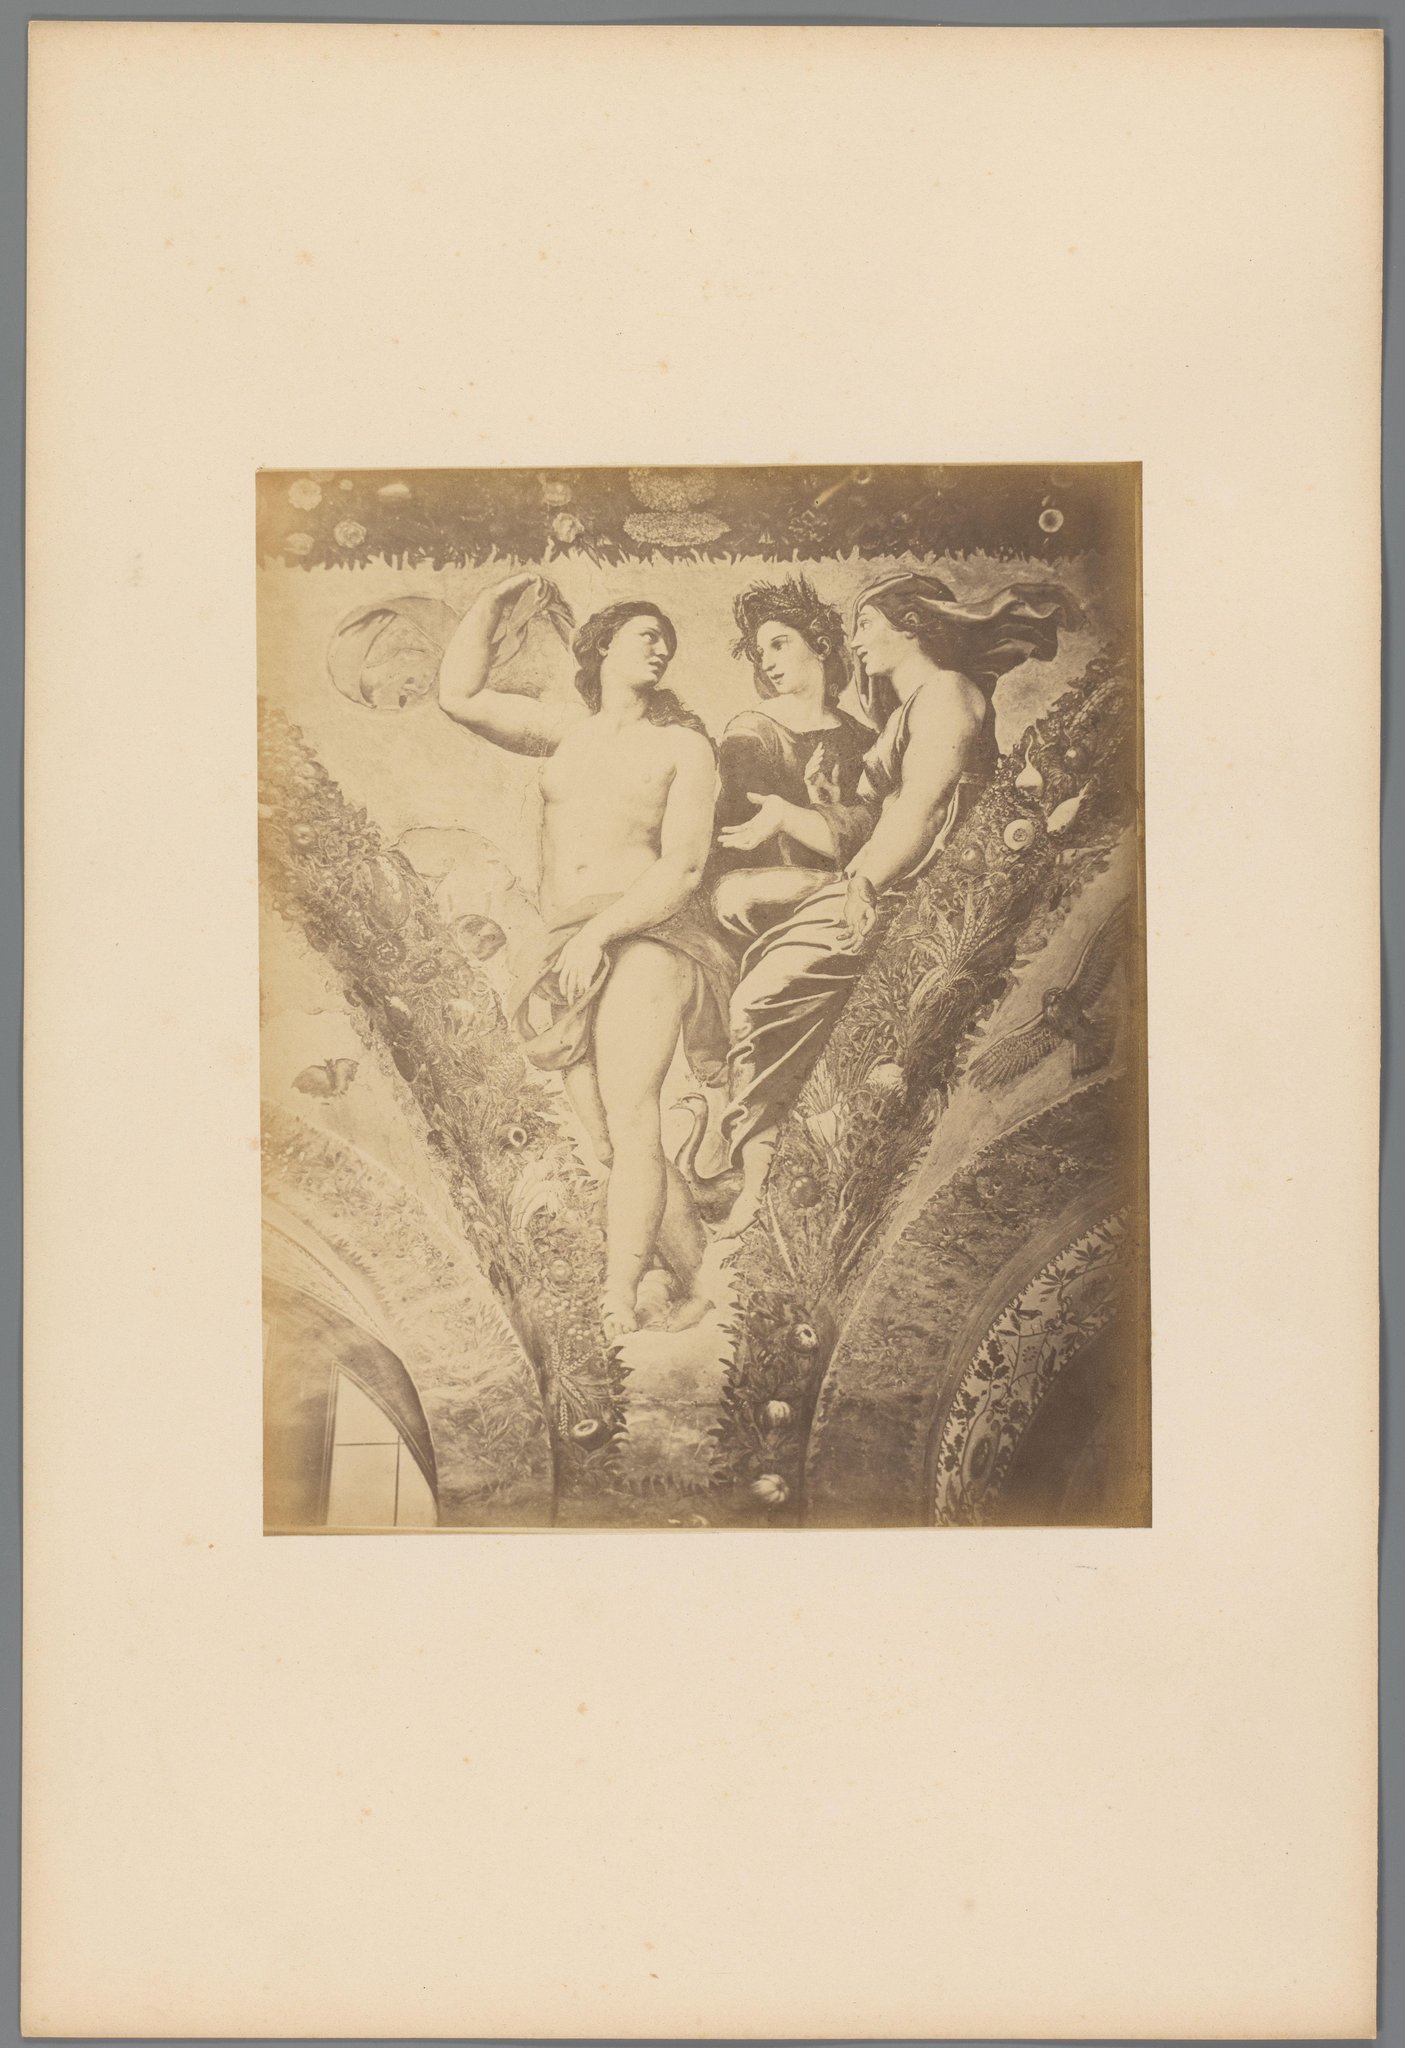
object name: reproduction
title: Fotoreproductie van het fresco Venus, Ceres en Juno naar Rafaël in de Villa Farnesina te Rome, Italië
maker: Anonymous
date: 1851-1900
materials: cardboard, paper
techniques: albumen print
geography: rome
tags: (story of) ceres (demeter), (story of) juno (hera), (story of) venus (aphrodite), wall-covering